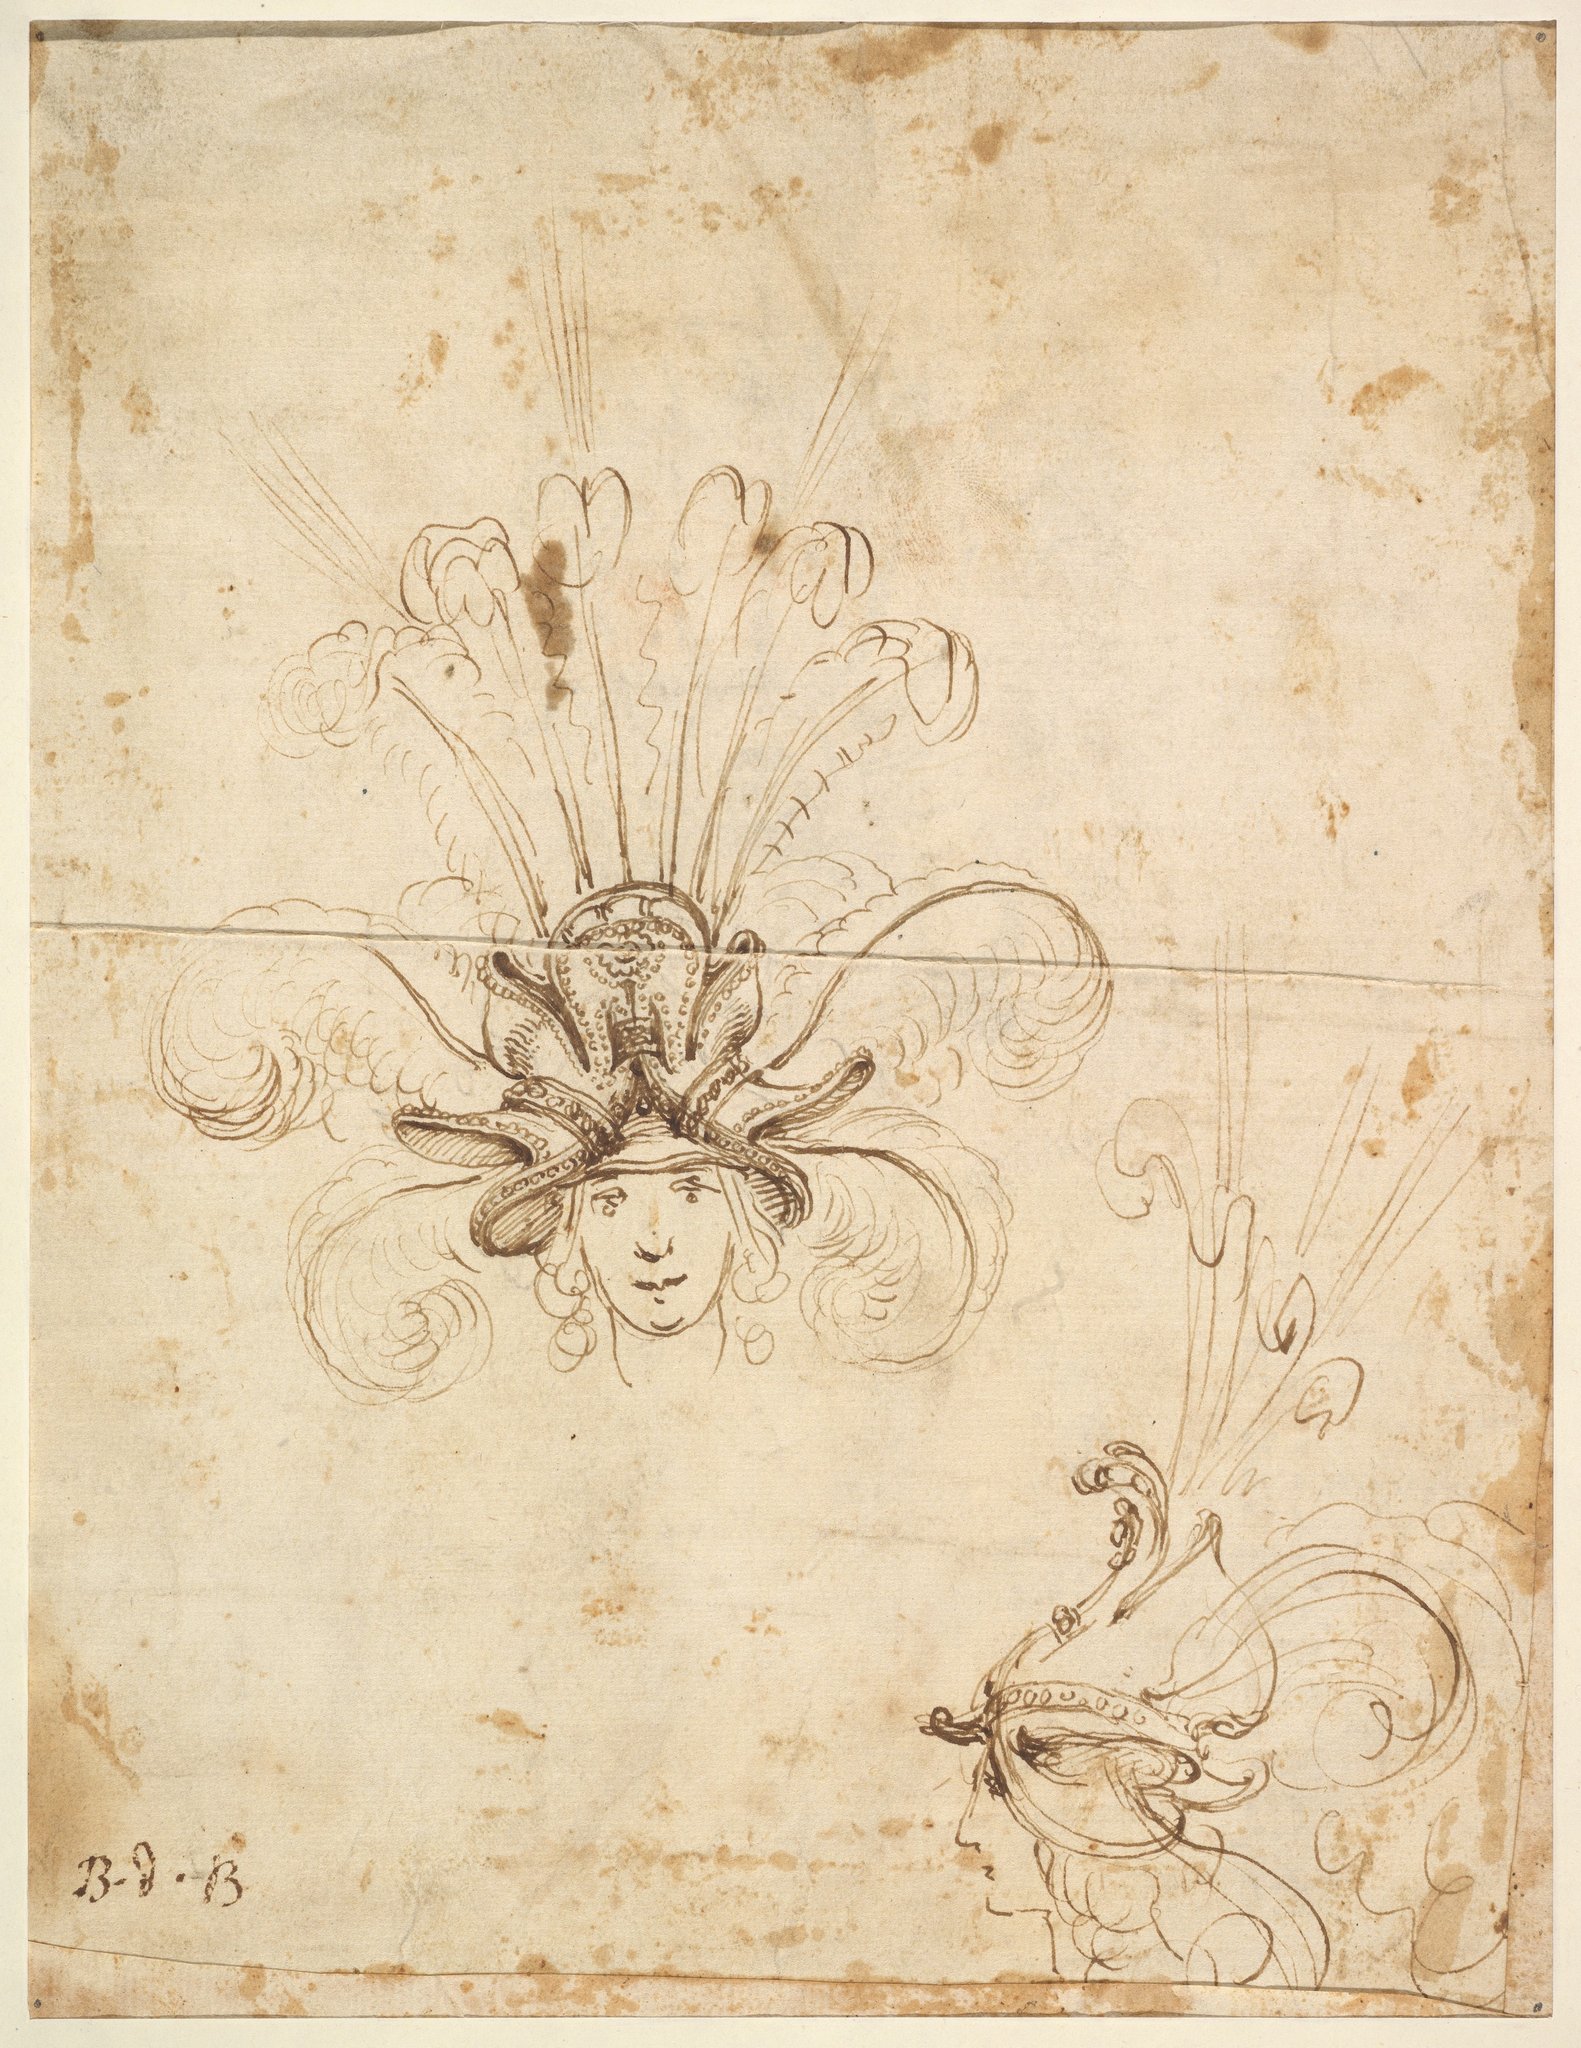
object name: collection ornament architecture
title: Design for a Headdress (front and side view)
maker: baccio del bianco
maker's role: artist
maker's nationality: italian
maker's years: 1604-1656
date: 1620-1656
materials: ink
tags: headdresses